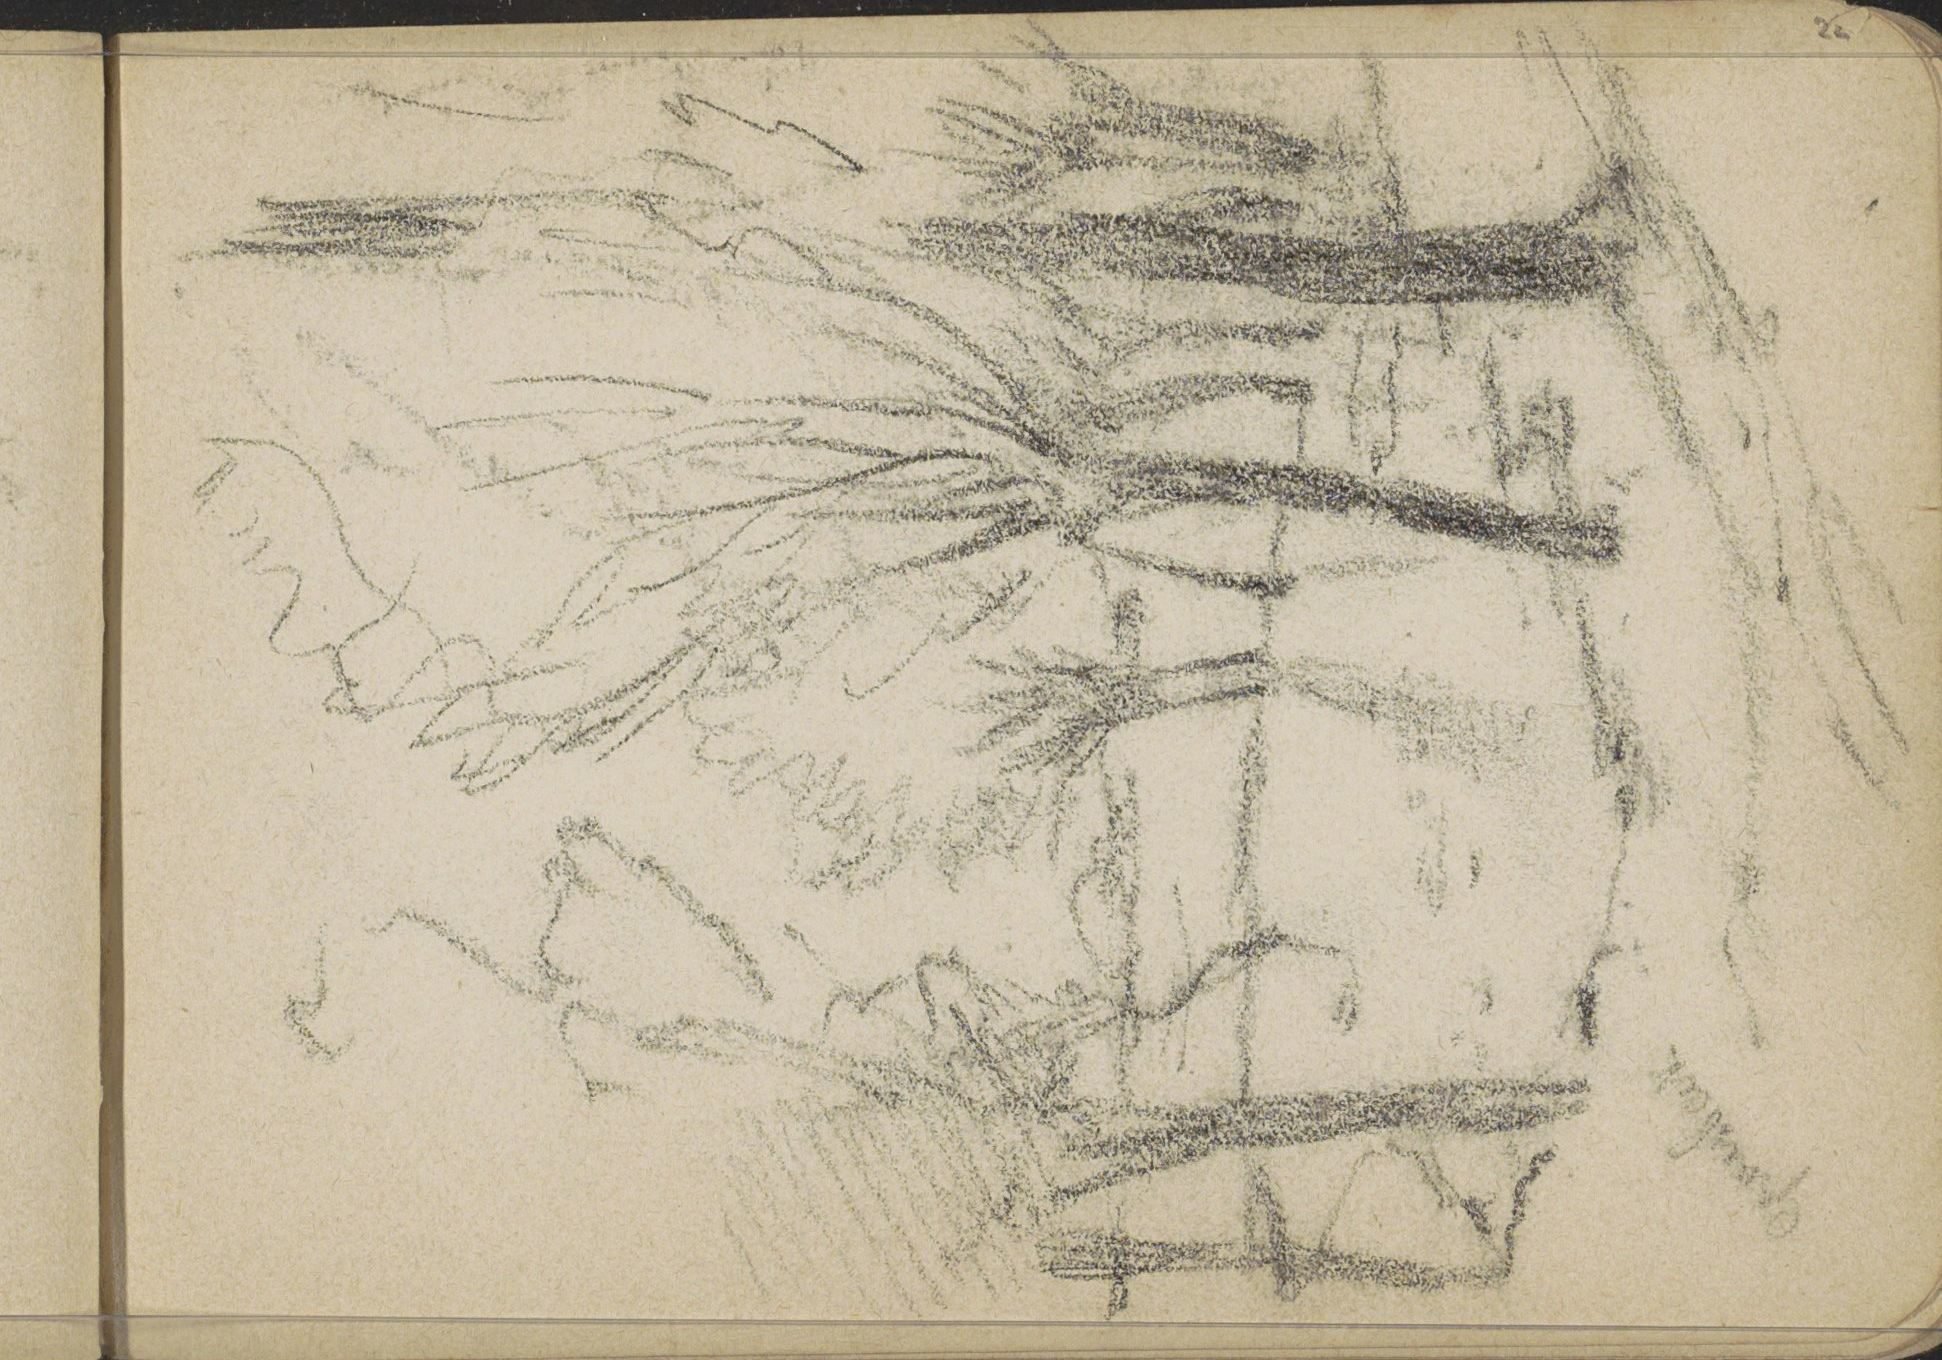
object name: sketchbook leaf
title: Bomen rond een plas te Groesbeek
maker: willem cornelis rip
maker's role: draughtsman, painter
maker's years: 1856-1922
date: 1896-1897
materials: chalk, paper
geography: groesbeek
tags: trees, pond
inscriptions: annotation: ‘Groesbeek’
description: Blad 22 recto uit een schetsboek met 44 bladen.